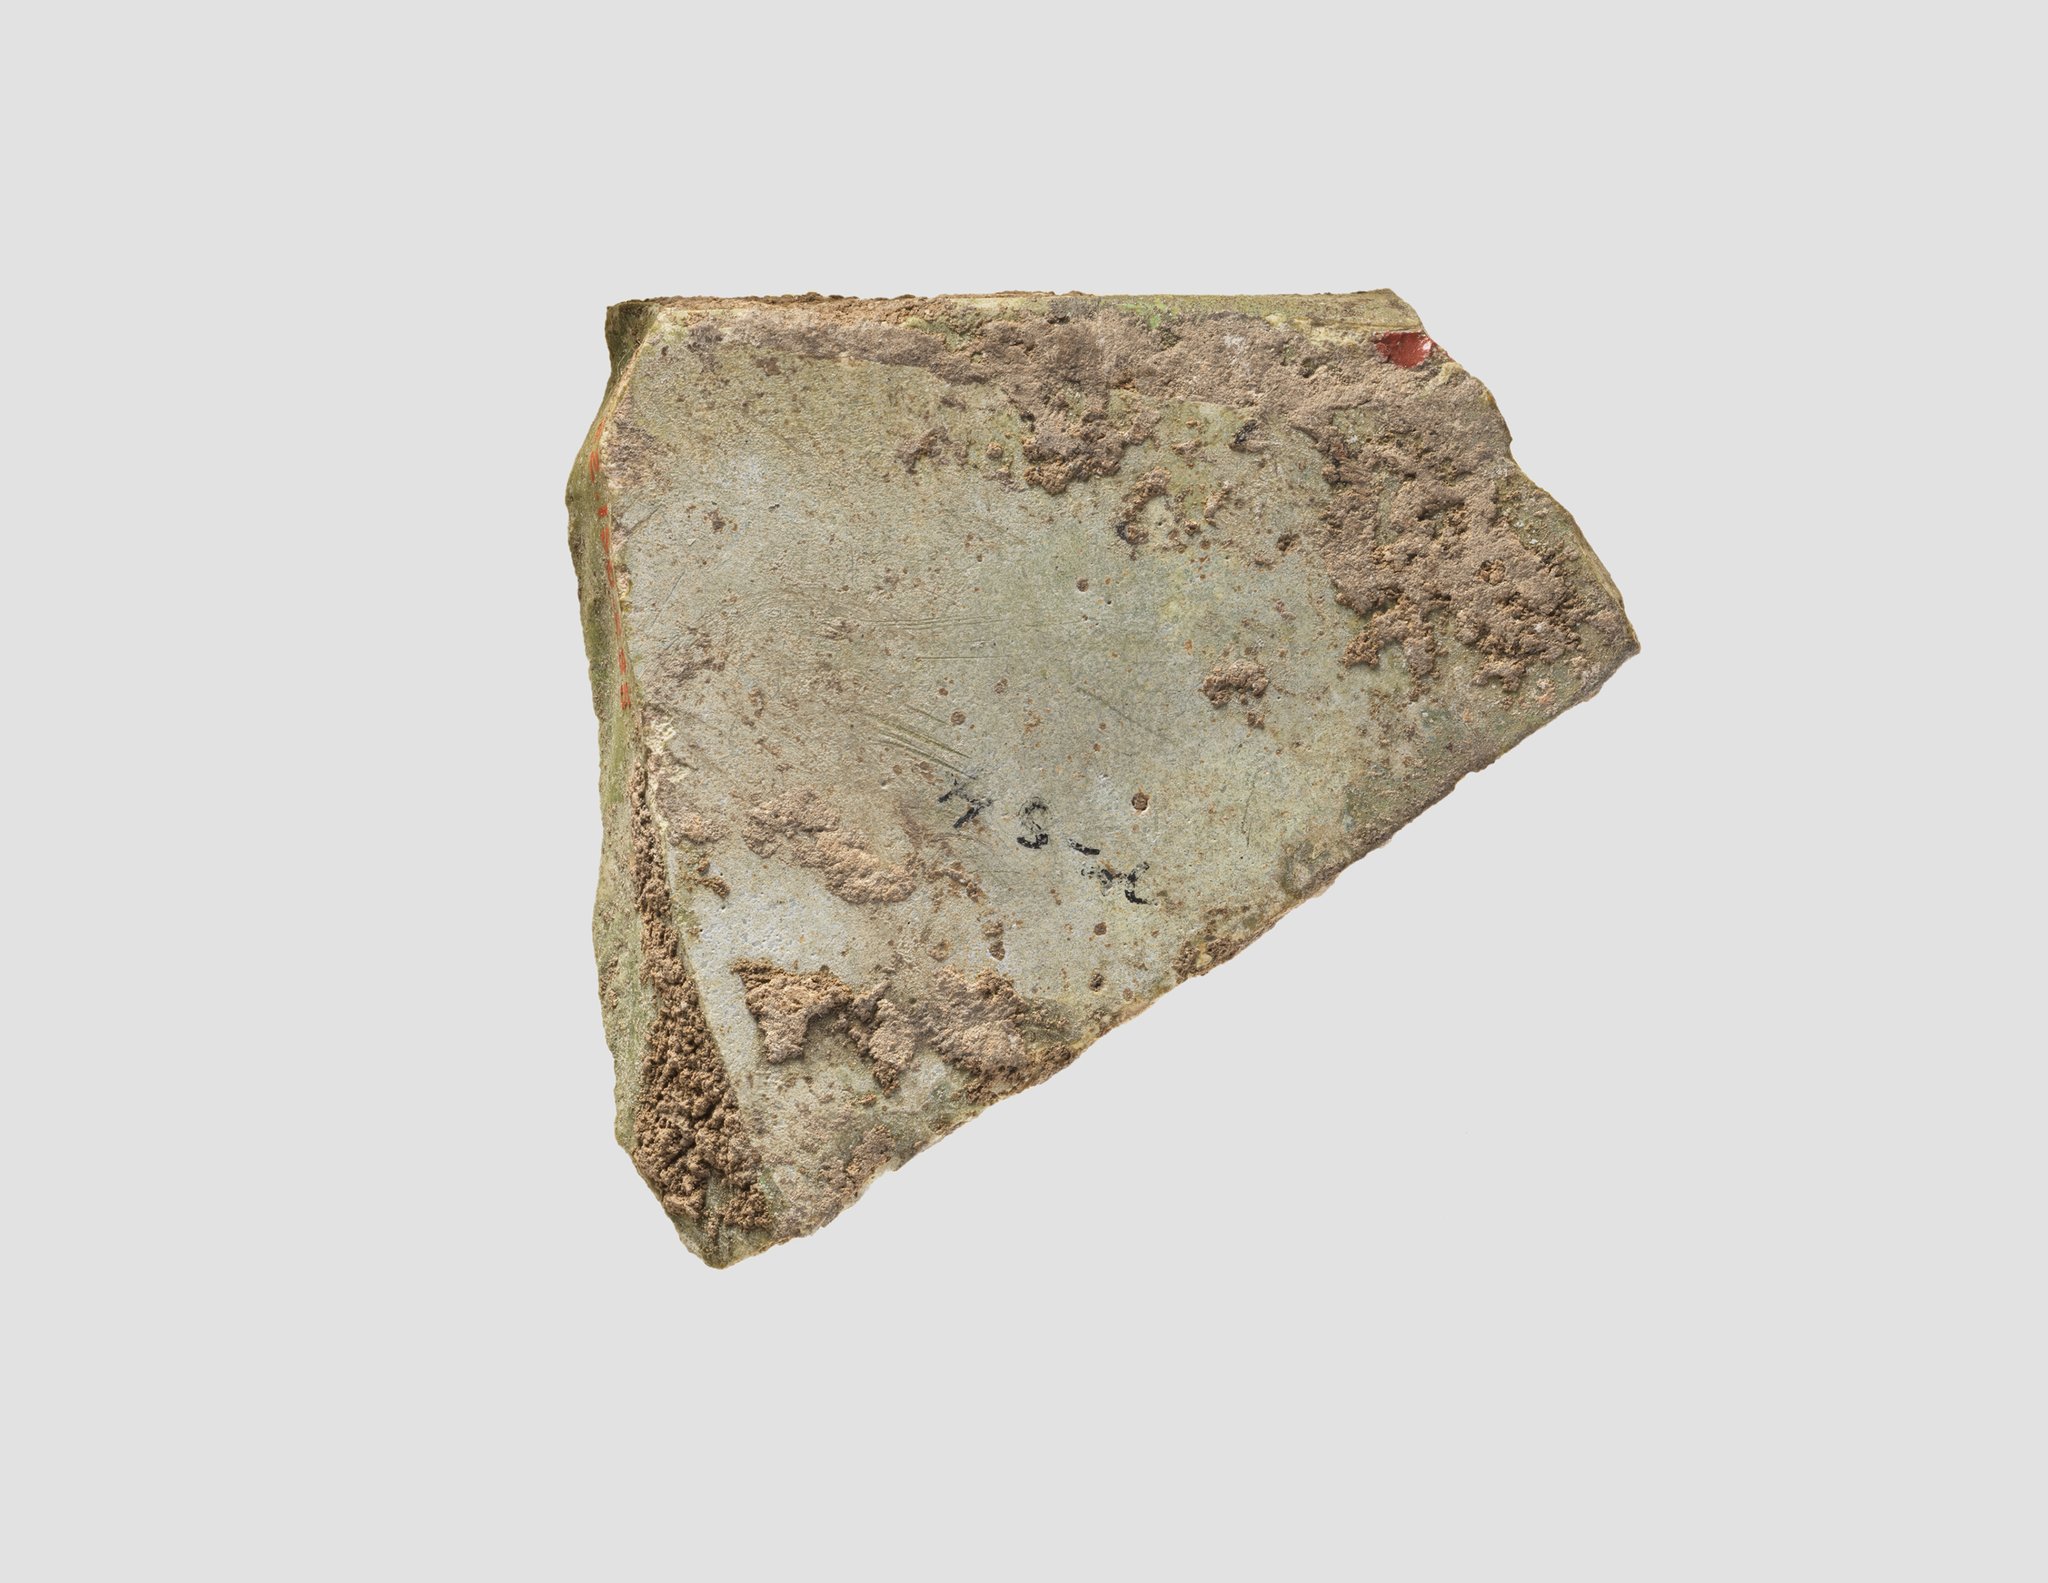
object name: plaque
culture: sasanian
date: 201-700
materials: glass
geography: mesopotamia